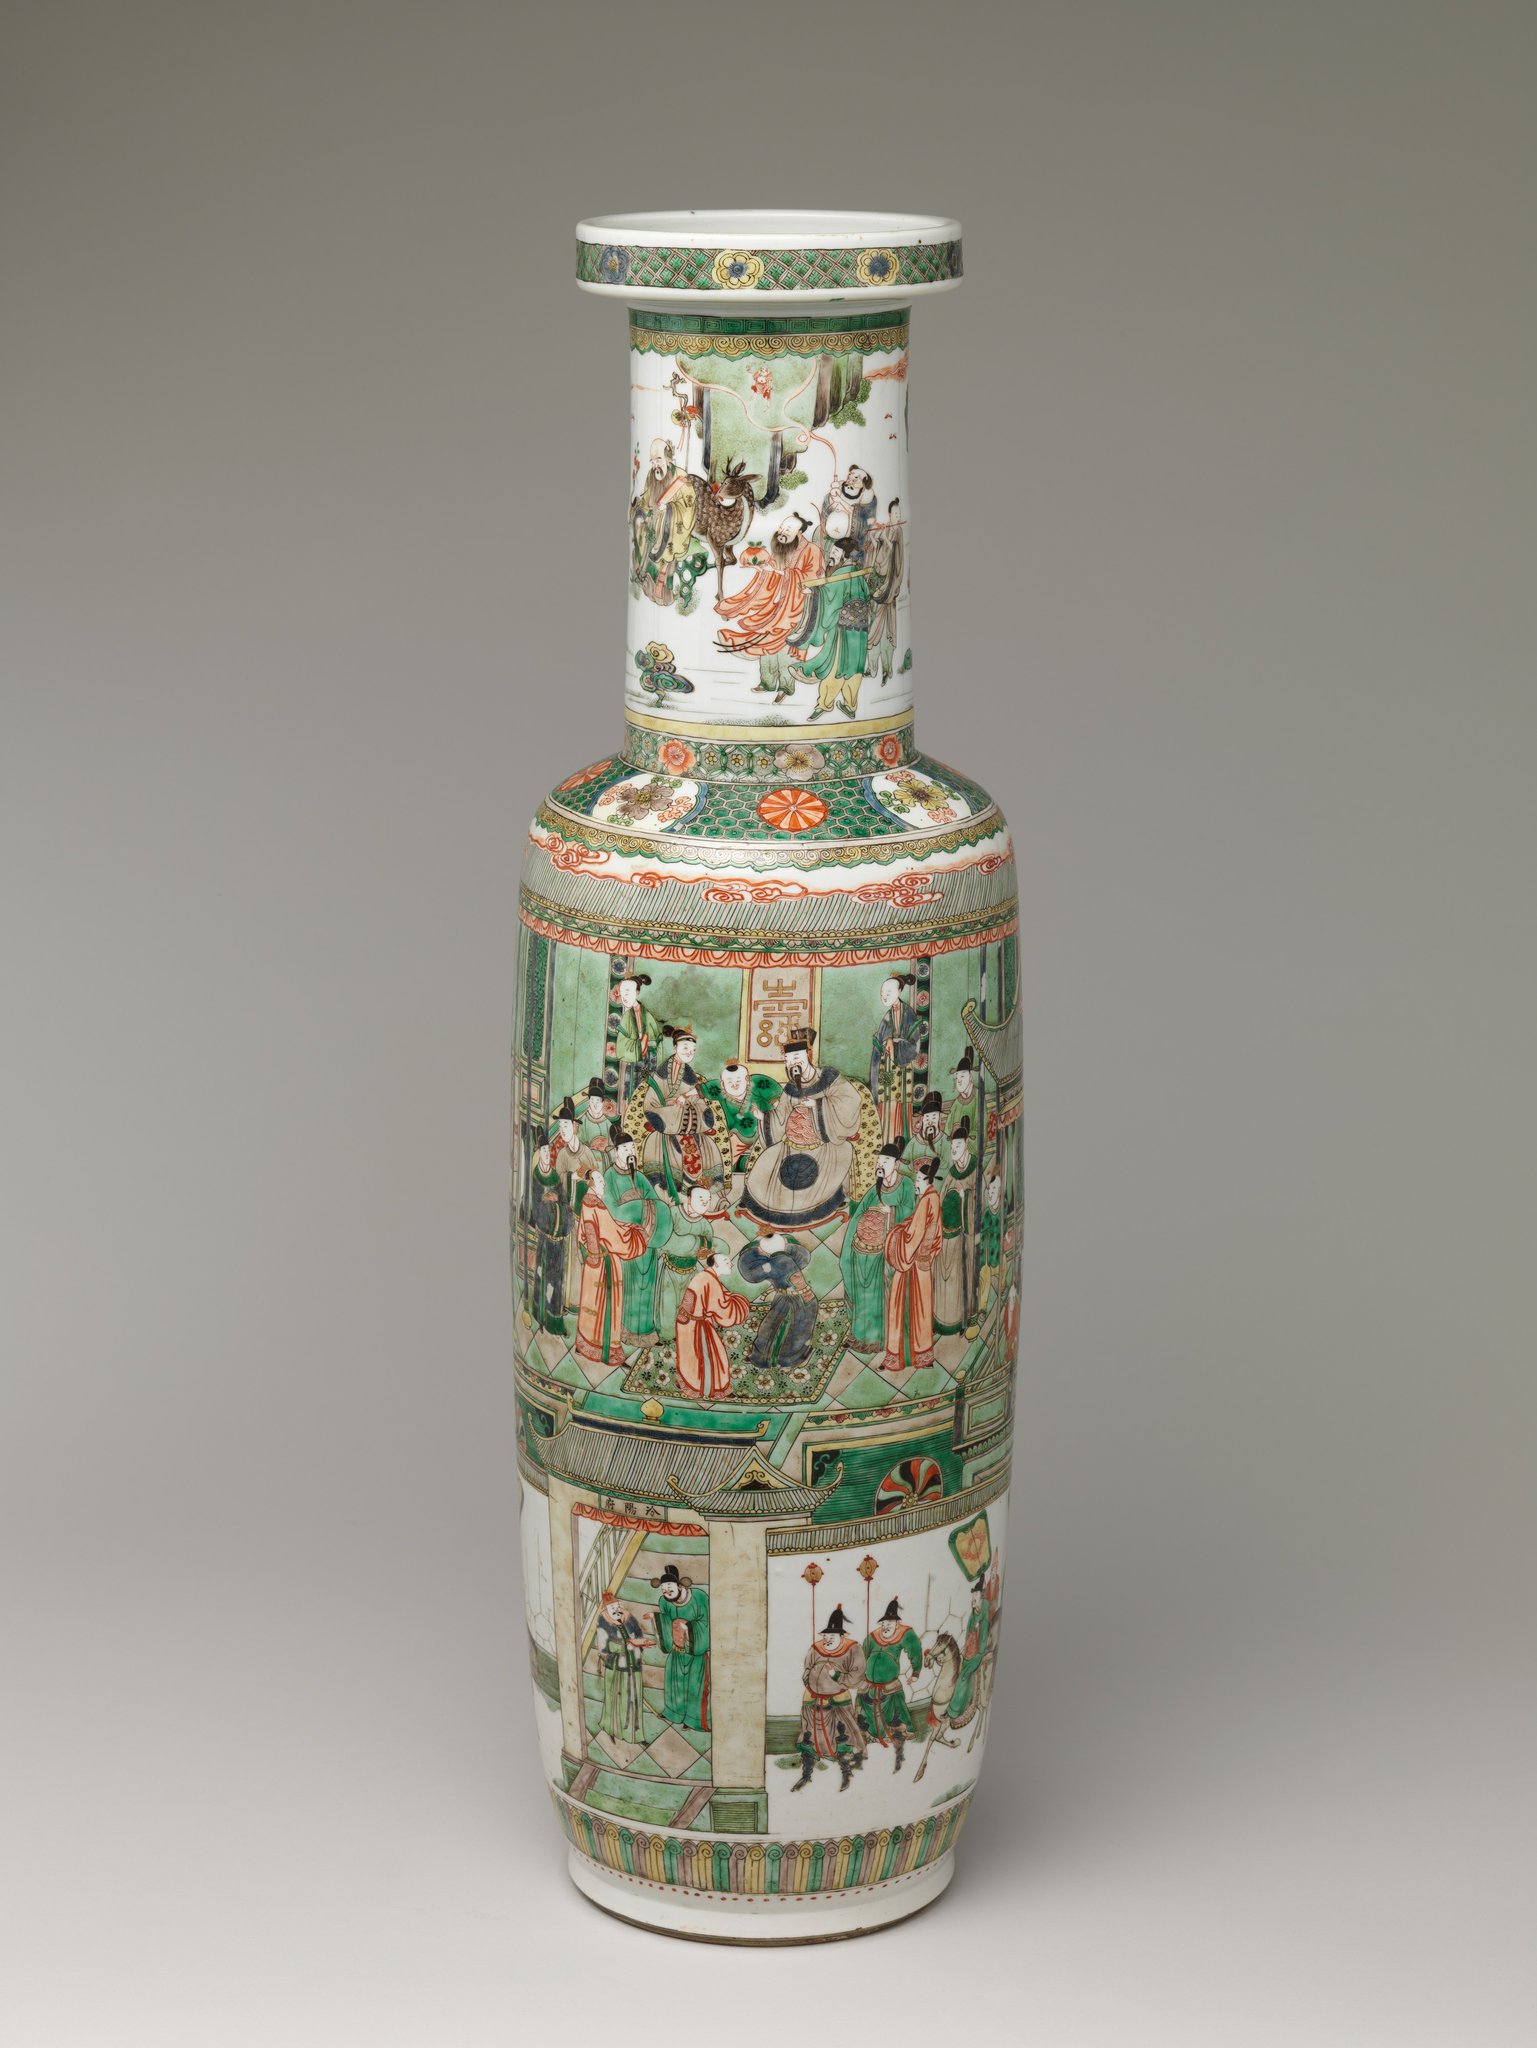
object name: vase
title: Vase with Birthday Reception for General Guo Ziyi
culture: chinese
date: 1662-1722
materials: enamel, porcelain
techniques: overglaze, painting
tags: men,women